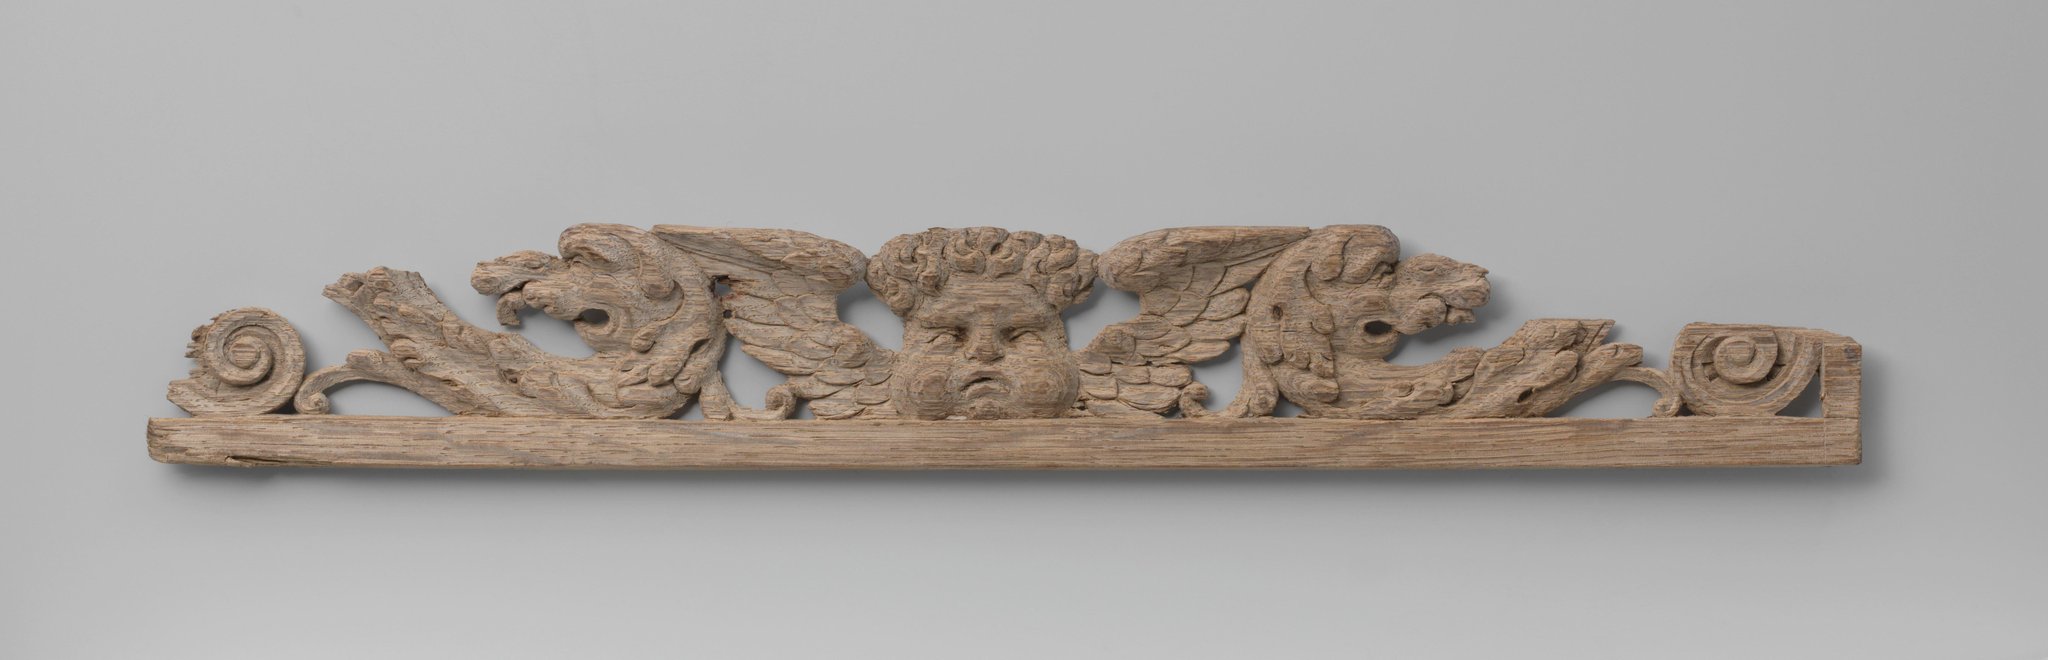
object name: fragment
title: Fragment of wood belonging to the organ from the Nicolaïkerk in Utrecht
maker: Anonymous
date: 1580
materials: wood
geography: northern netherlands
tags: nicolaïkerk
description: Sierlijst van hout met een engelenkop met twee vleugels geflankeerd twee monsterkoppen en profile gezien. Onderdeel van het orgel afkomstig uit de Nicolaïkerk in Utrecht (BK-NM-8166).